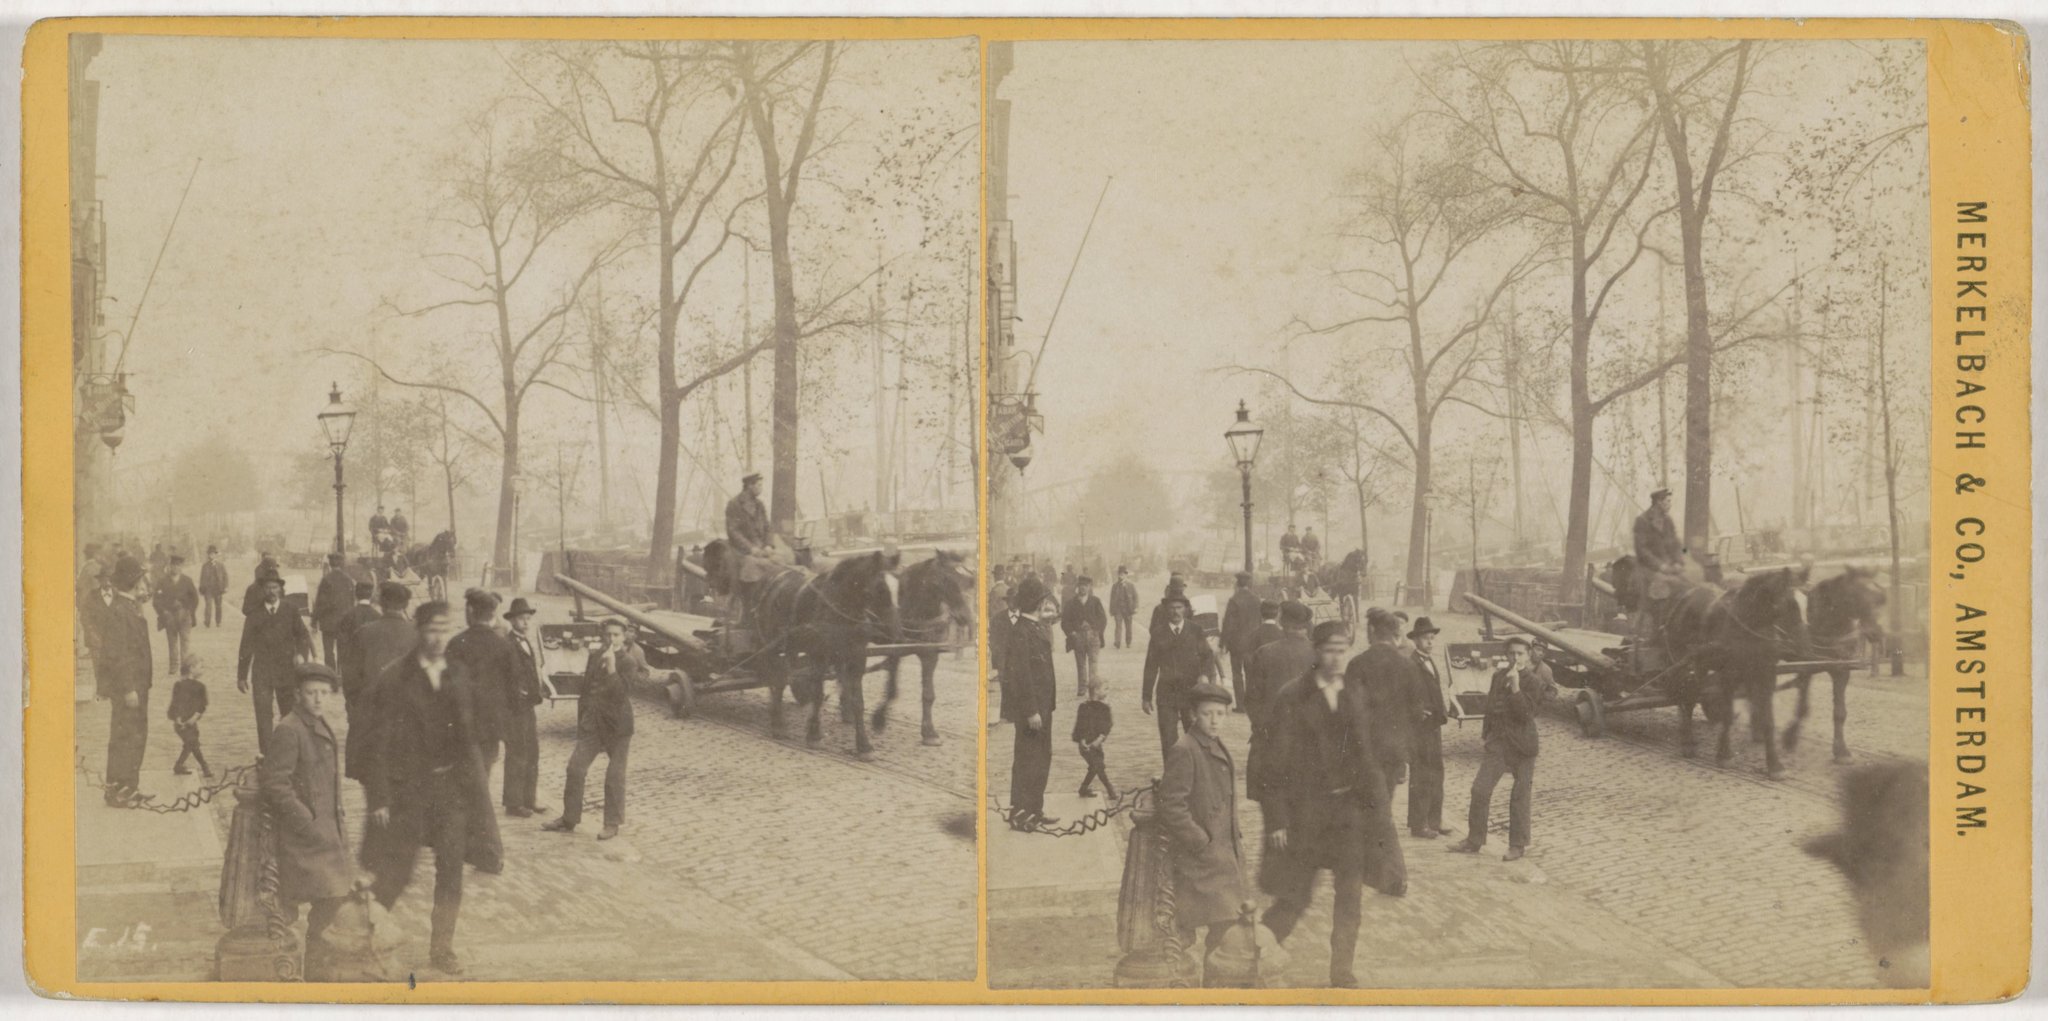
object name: stereograph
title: De Boompjes te Rotterdam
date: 1900-1902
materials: cardboard, paper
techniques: albumen print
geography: amsterdam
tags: four-wheeled vehicle drawn by two animals, street, quay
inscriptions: number: ‘E.15.’, inscription: ‘Een der drukste gedeelten der stad. Rechts de Maas, met Rijnaken en beurt-/ schepen. Op den achtergrond, ten O. van den beschouwer, de groote spoorbrug over de Maas.’, number: ‘15.’